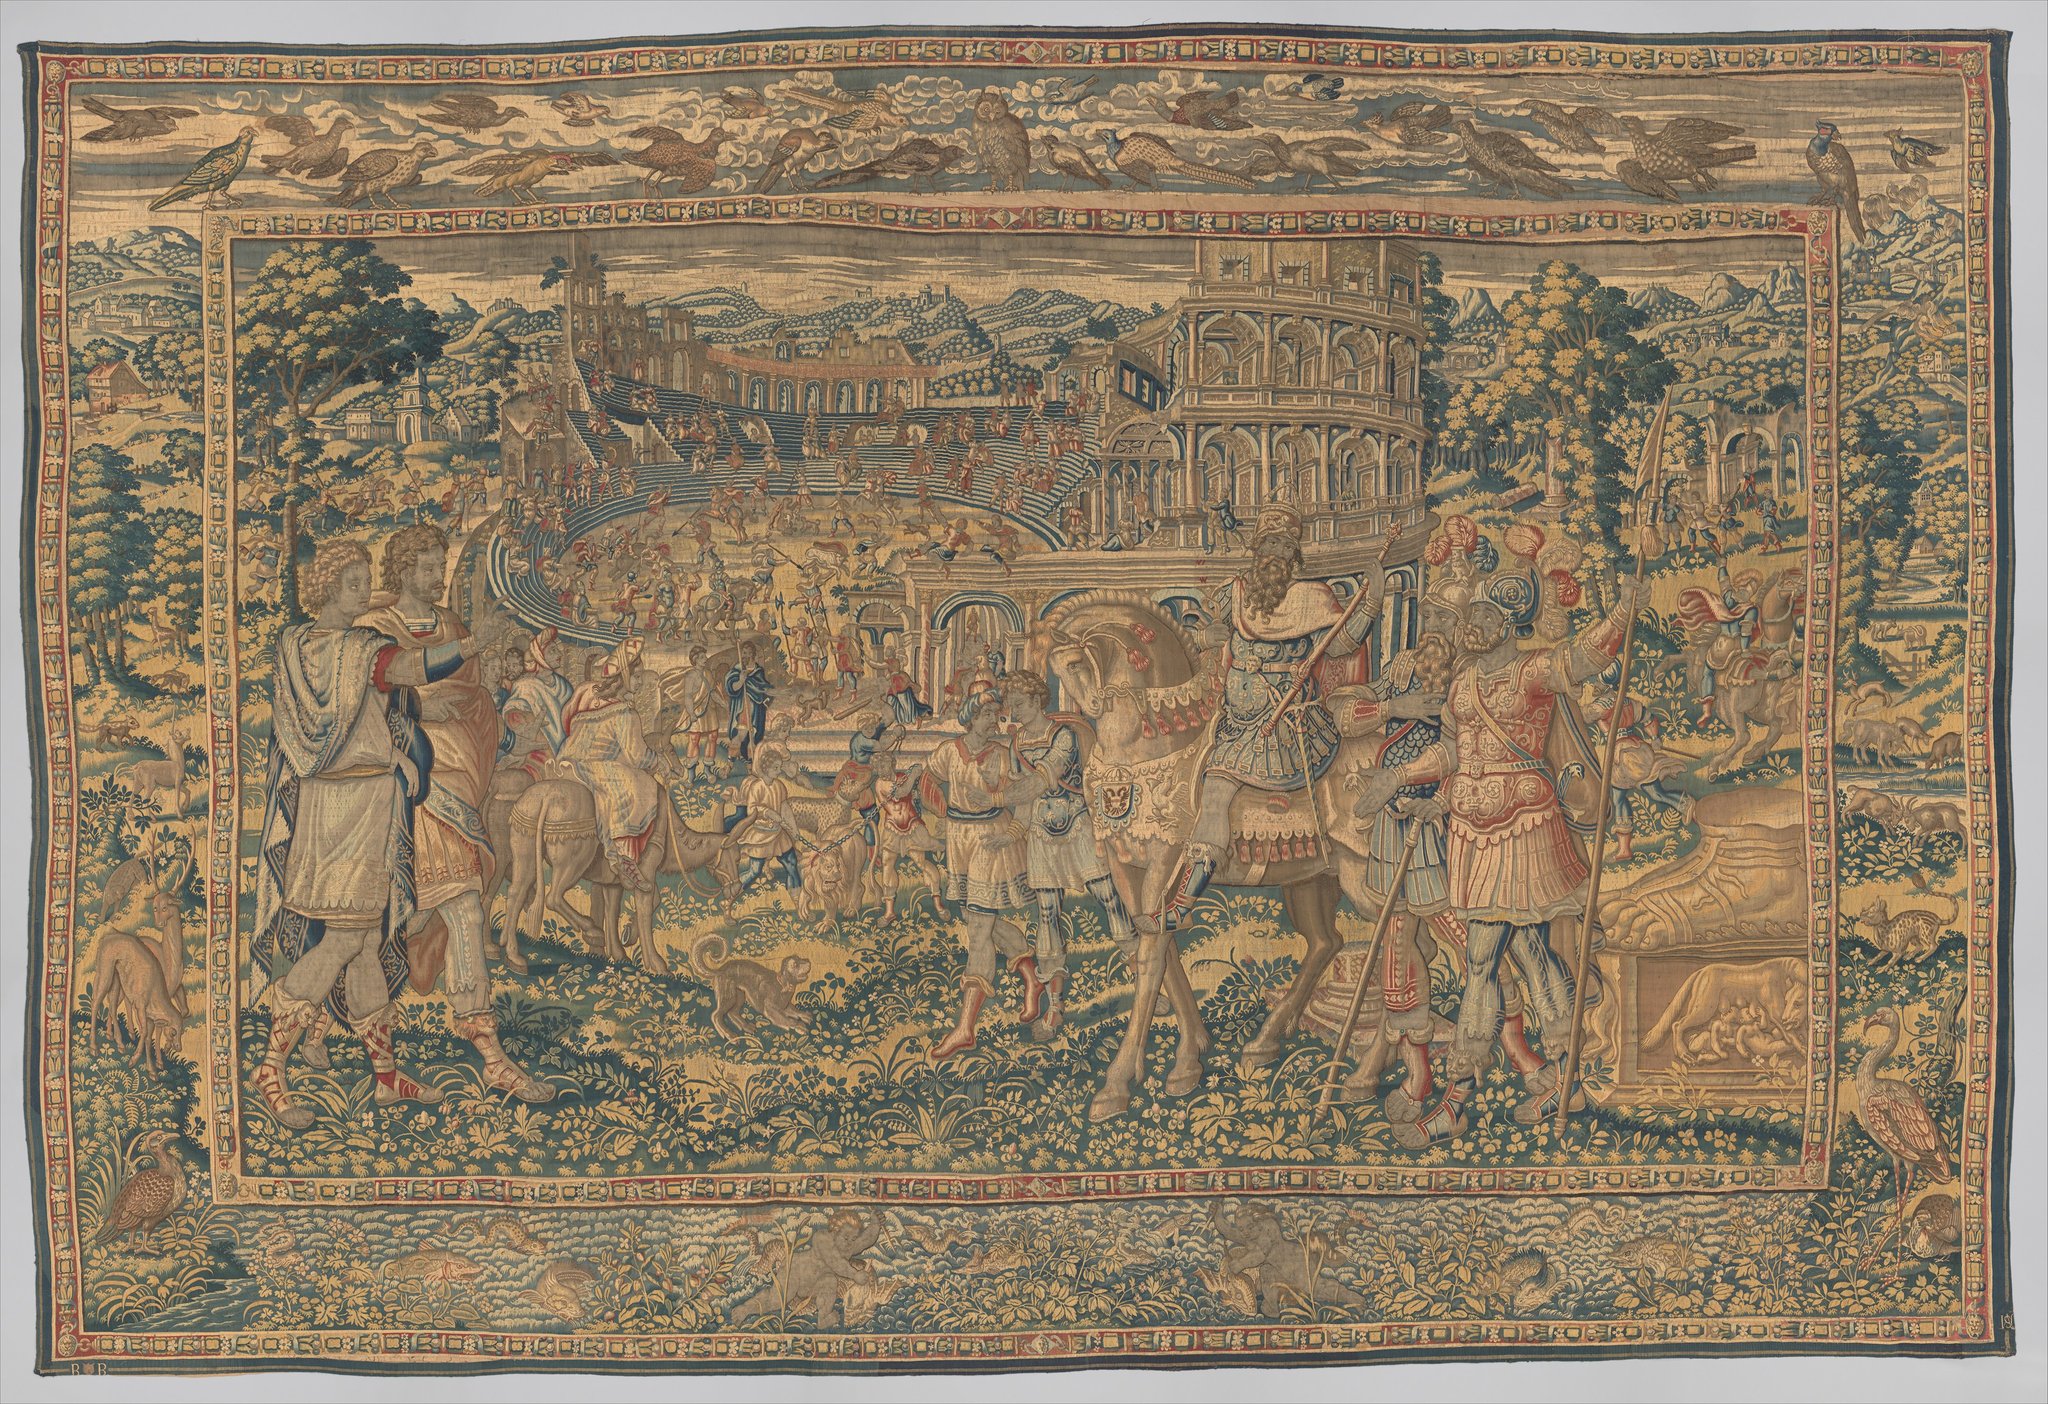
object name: tapestry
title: The Colosseum from a set of The Wonders of the World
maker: maarten van heemskerck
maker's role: designer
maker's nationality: netherlandish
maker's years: 1498-1574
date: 1575-1600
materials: silk, wool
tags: birds,ruins,men,horses